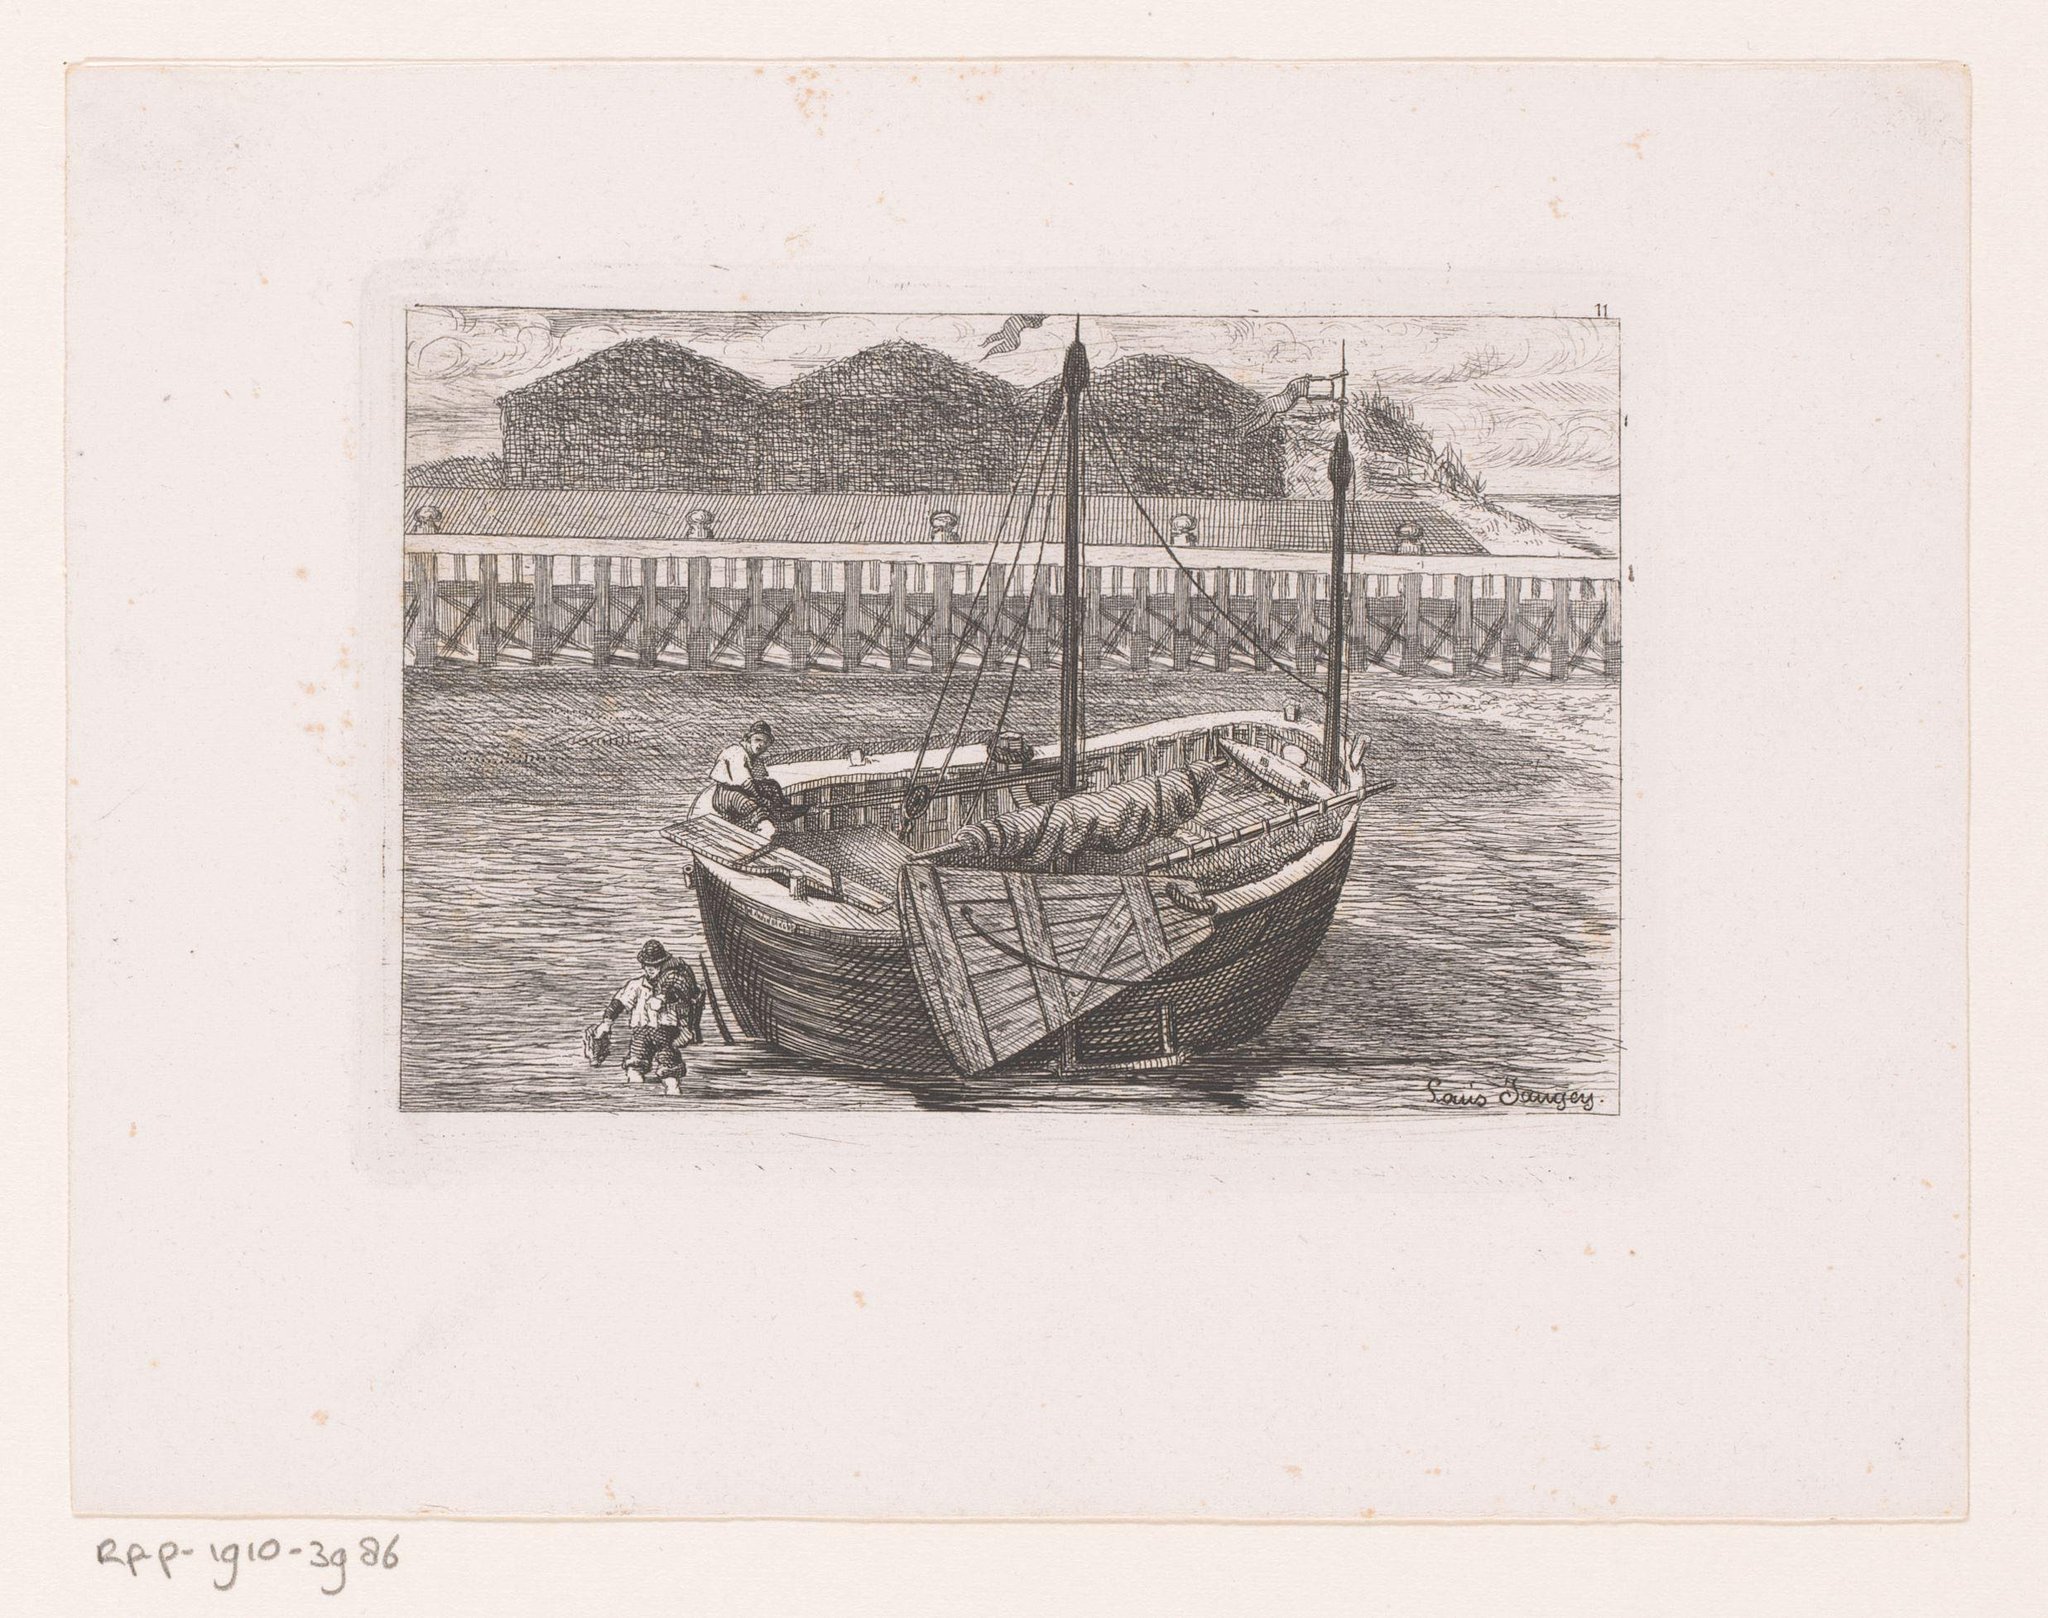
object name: print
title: Gezicht op een schip met zwaarden bij een pier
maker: louis jaugey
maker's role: print maker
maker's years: 1837-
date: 1850-1899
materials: paper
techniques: etching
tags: sailing-ship, sailing-boat, pier, quay, wharf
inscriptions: collector's mark: Lugt 2228